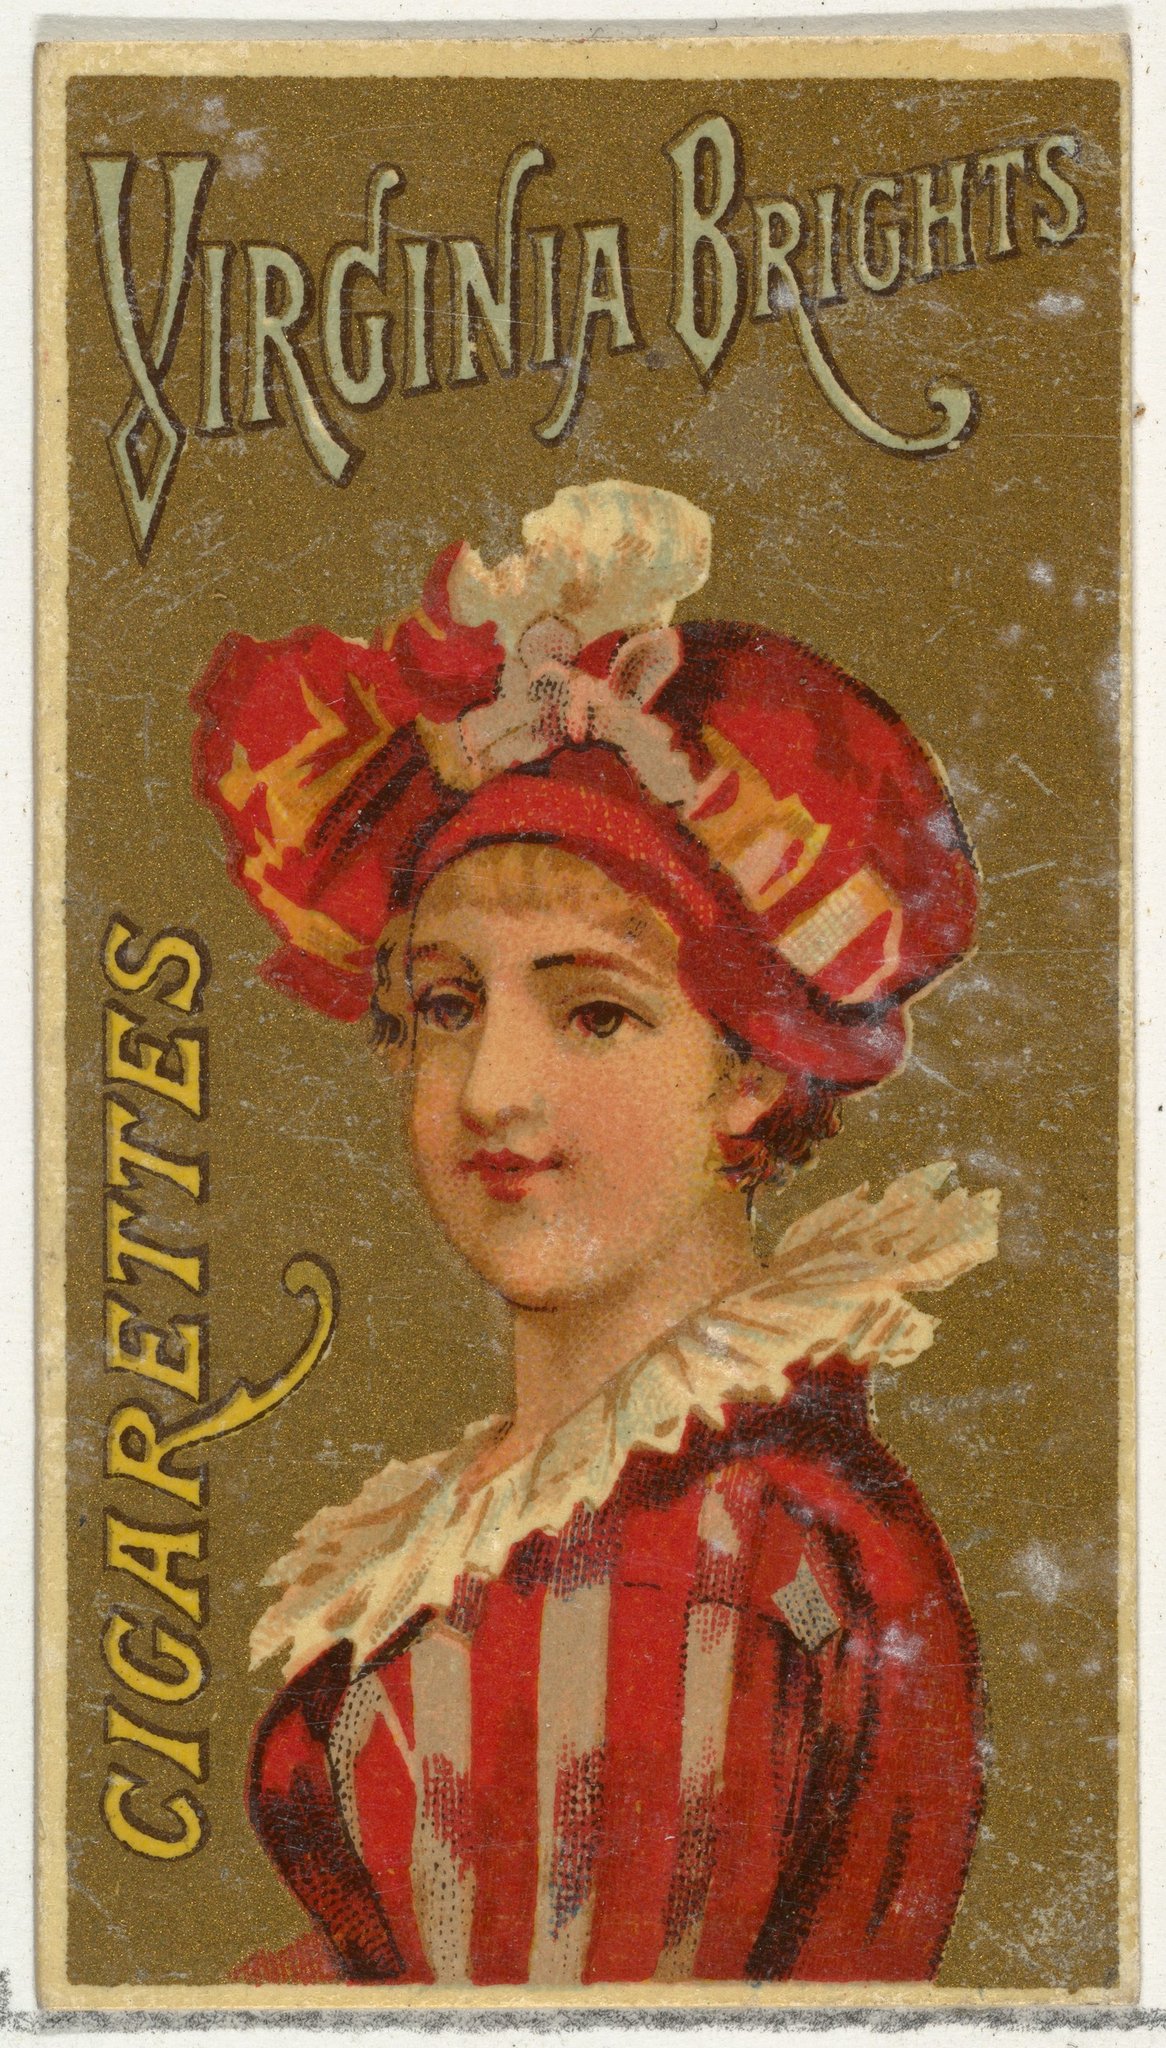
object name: print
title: From the Girls and Children series (N64) promoting Virginia Brights Cigarettes for Allen & Ginter brand tobacco products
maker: allen & ginter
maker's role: publisher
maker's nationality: american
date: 1886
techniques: color lithograph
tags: women